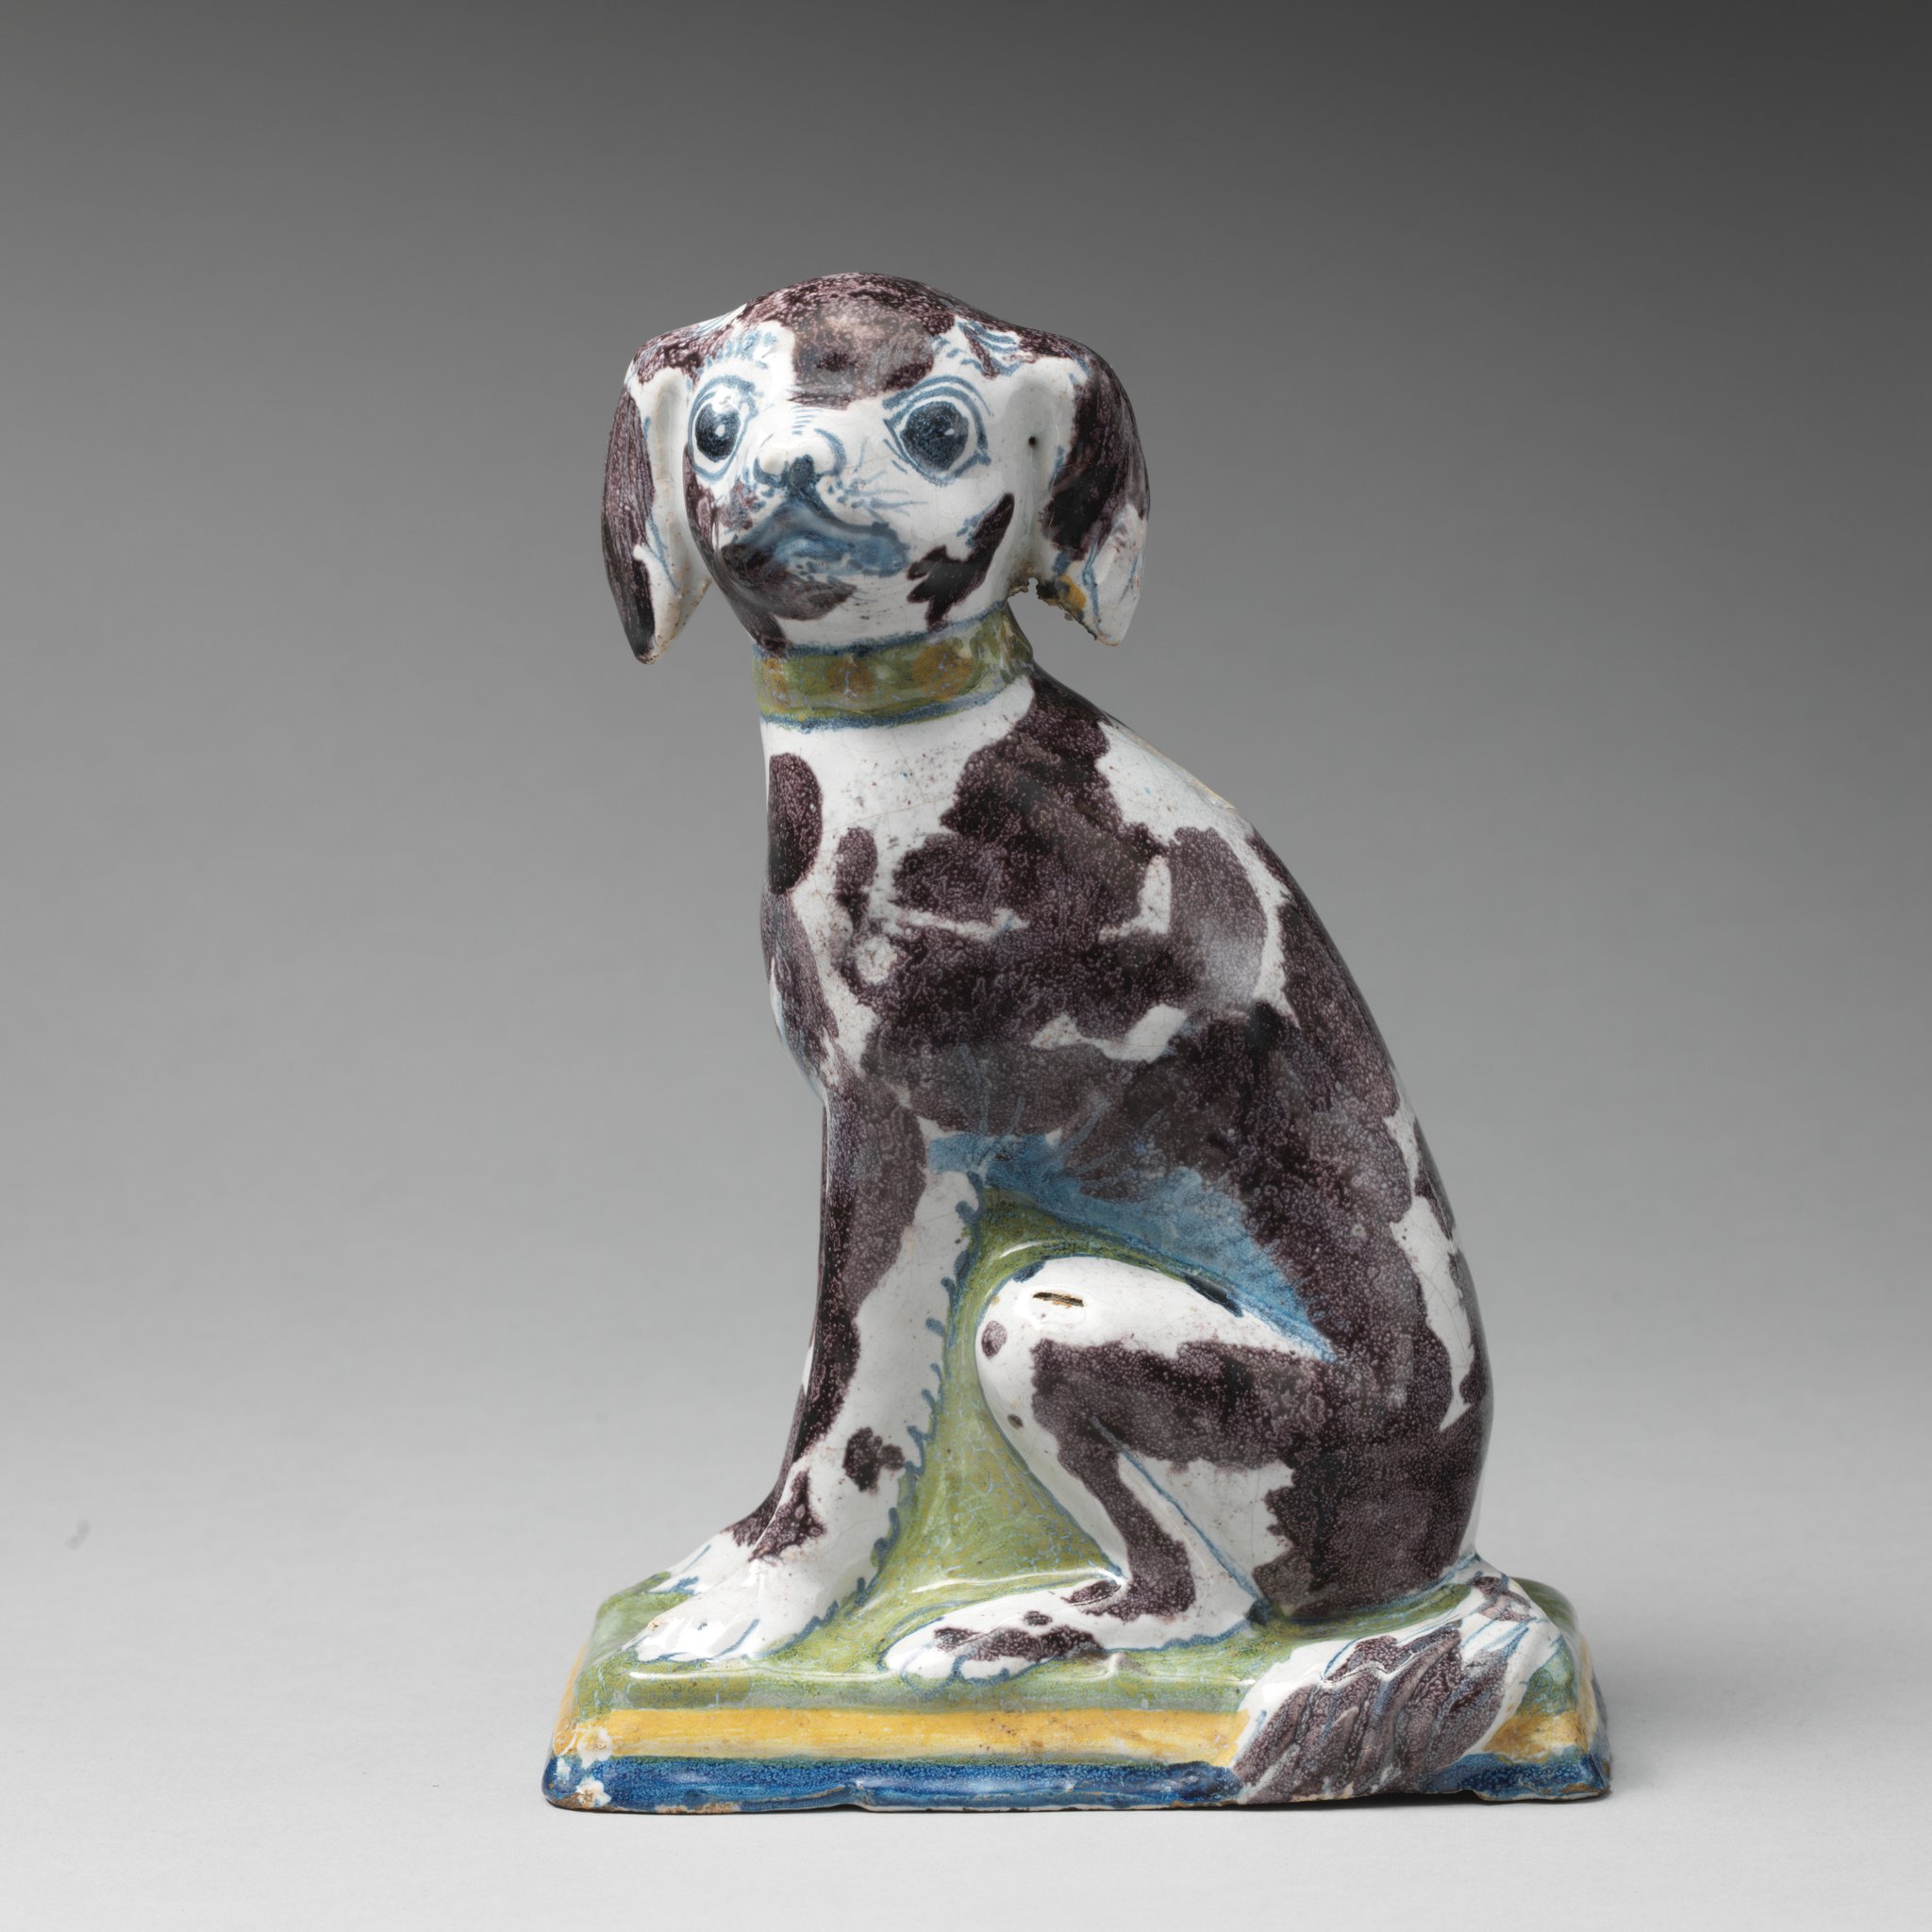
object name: money box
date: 1701-1800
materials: earthenware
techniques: glazing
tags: dogs